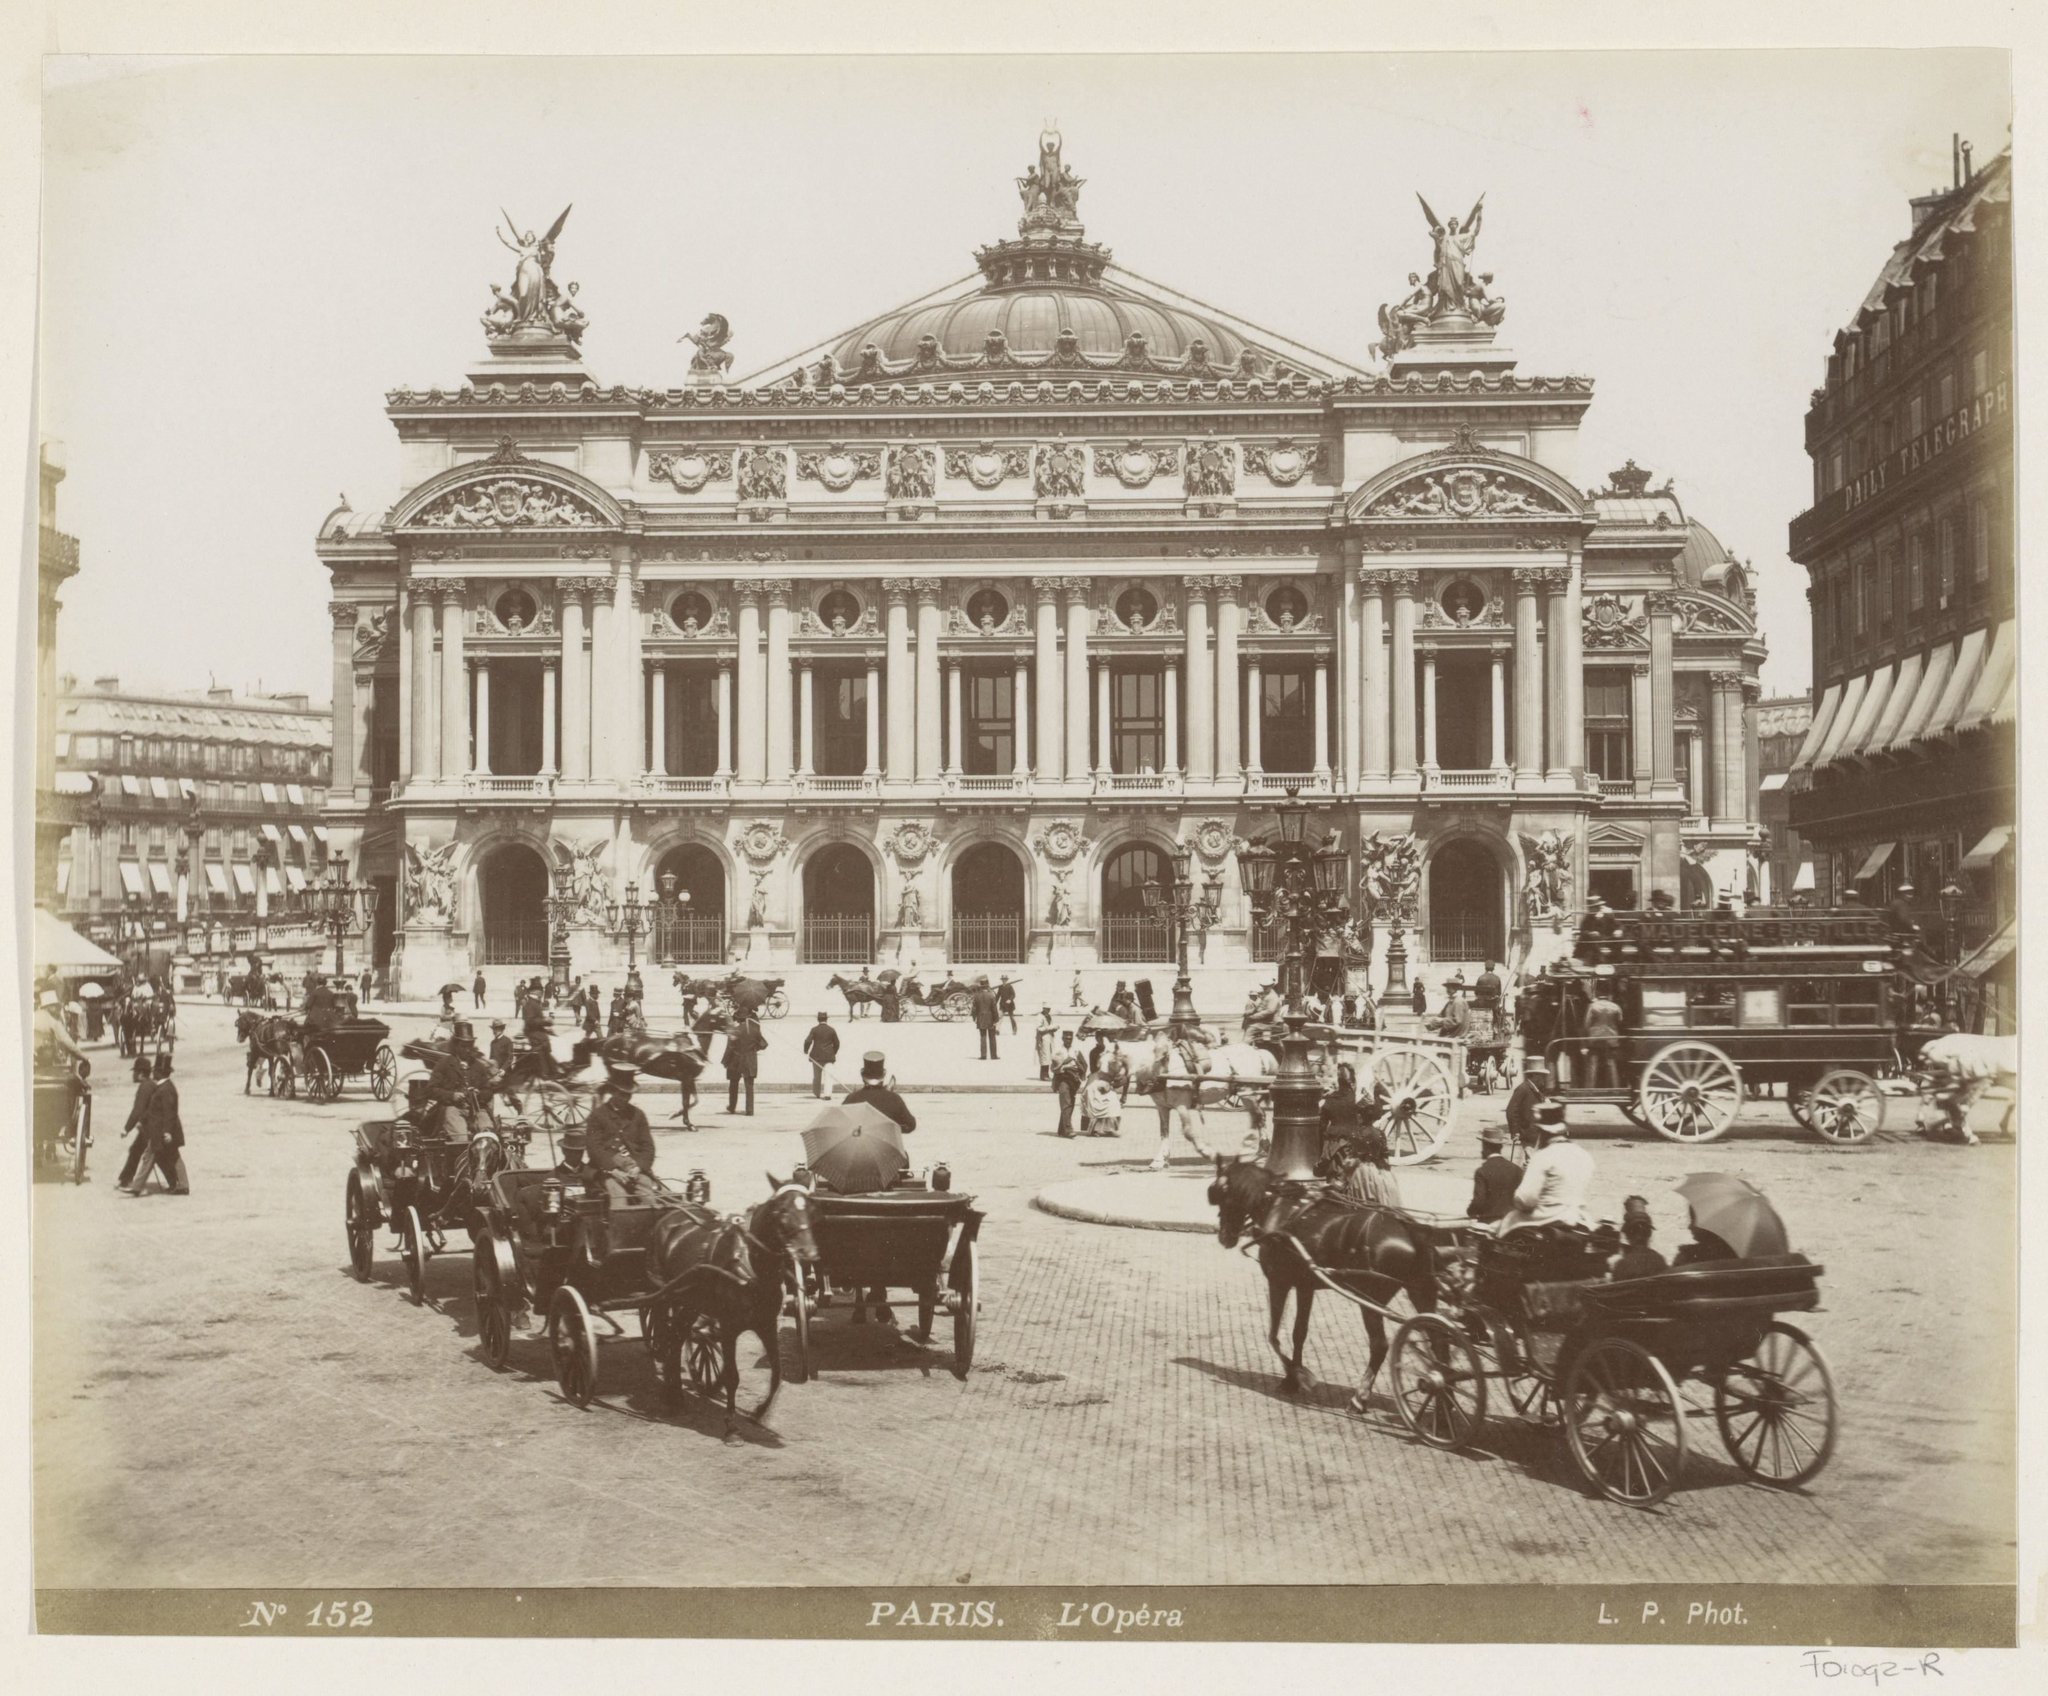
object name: photograph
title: PARIS. L'Opéra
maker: louis antoine pamard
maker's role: fotograaf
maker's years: 1840-1893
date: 1880-1900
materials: cardboard, paper, photographic support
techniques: albumen print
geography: paris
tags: diligence, omnibus, horse-tram, four-wheeled, animal-drawn vehicle, e.g.: cab, carriage, coach, opera house, street (+ city(-scape) with figures, staffage)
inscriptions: negative number: ‘152’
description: Onderdeel van Reisalbum met foto's van bezienswaardigheden in België en Frankrijk.